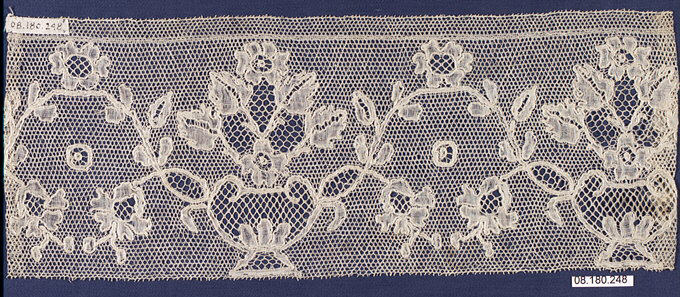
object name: fragment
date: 1701-1800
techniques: lace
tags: flowers,leaves